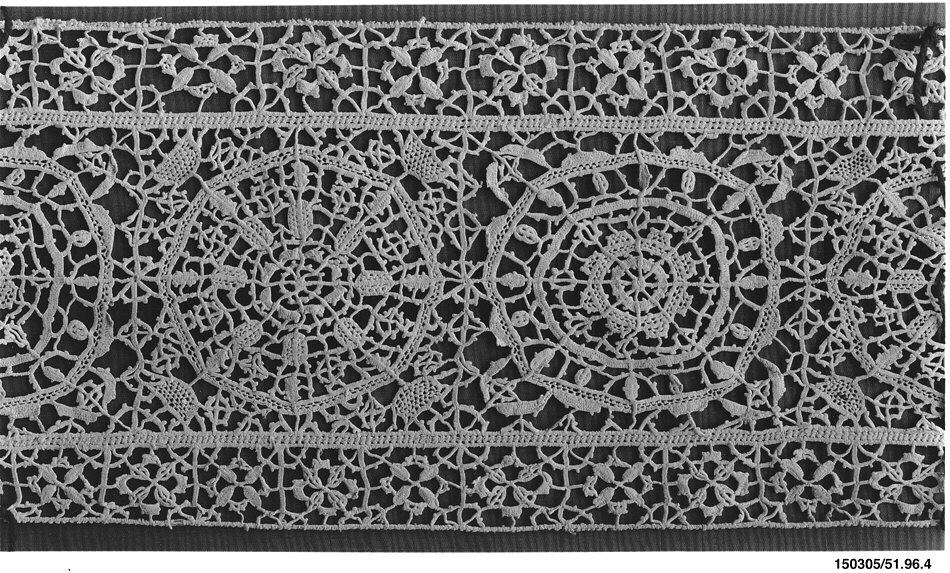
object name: insertion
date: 1567-1600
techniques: lace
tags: flowers